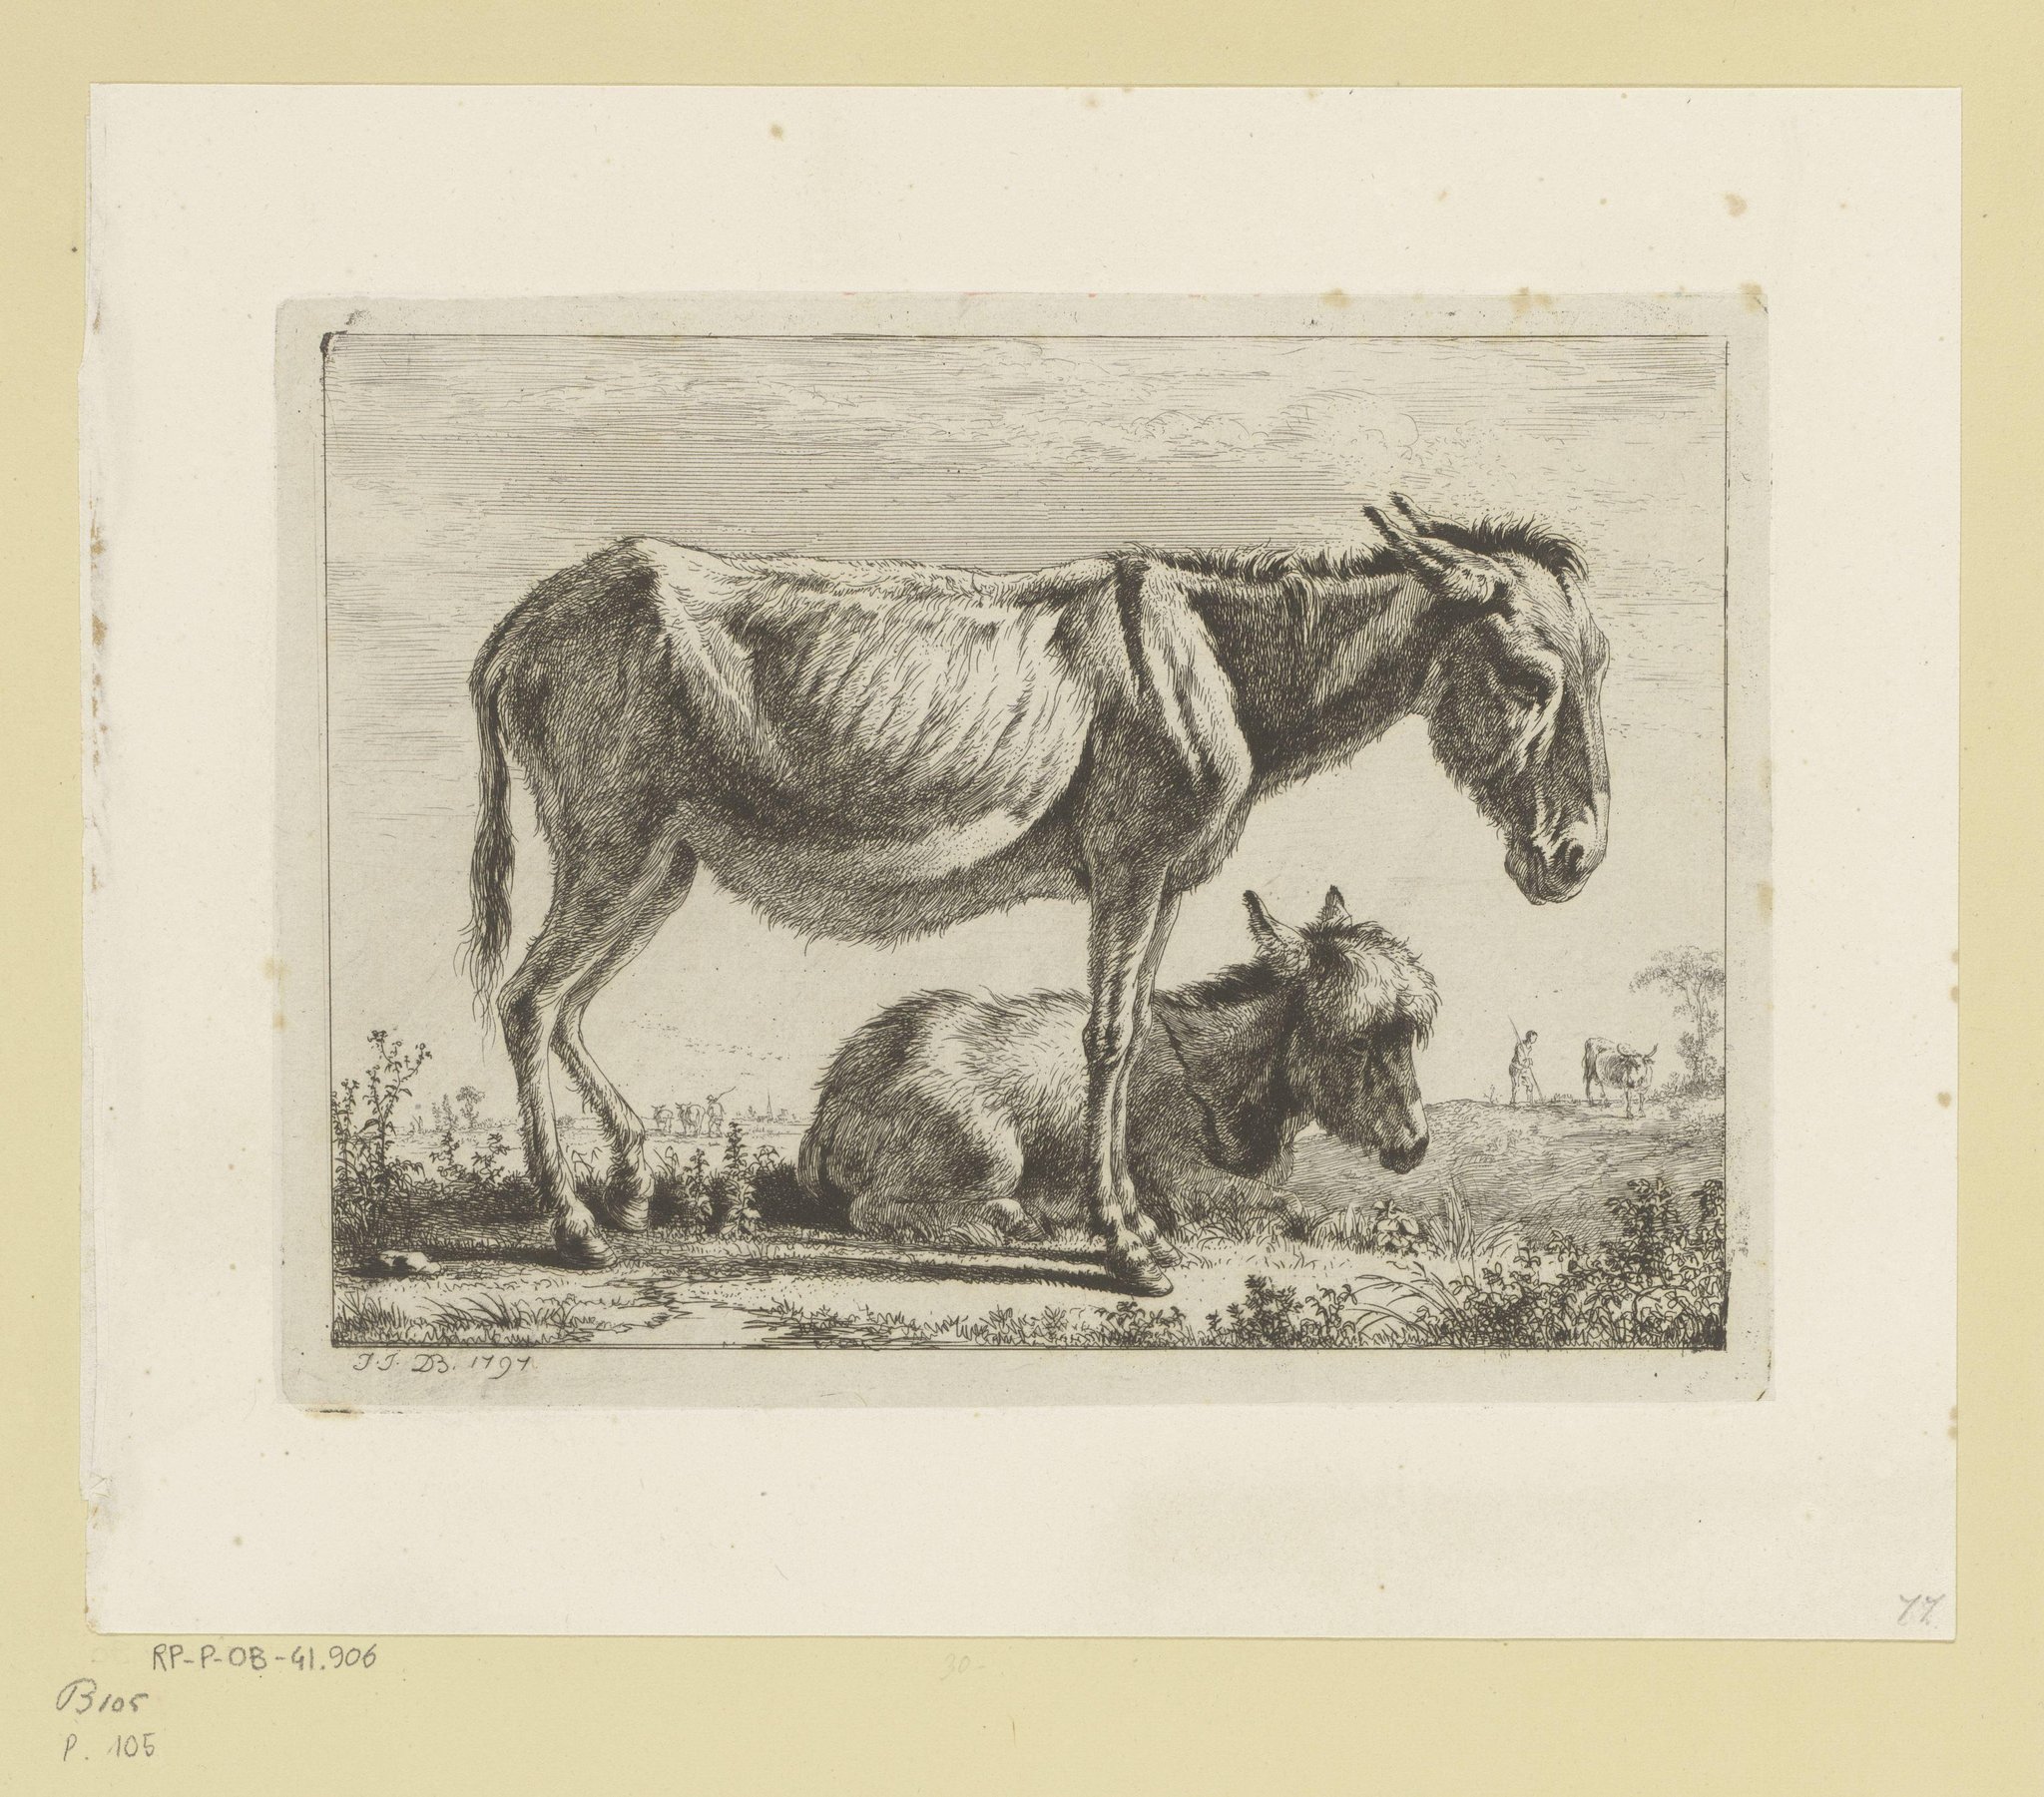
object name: print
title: Ezel met jong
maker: jean jacques de boissieu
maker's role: draughtsman, print maker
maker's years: 1736-1810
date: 1791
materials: paper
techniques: etching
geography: france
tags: ass, donkey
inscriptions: collector's mark: Lugt 12